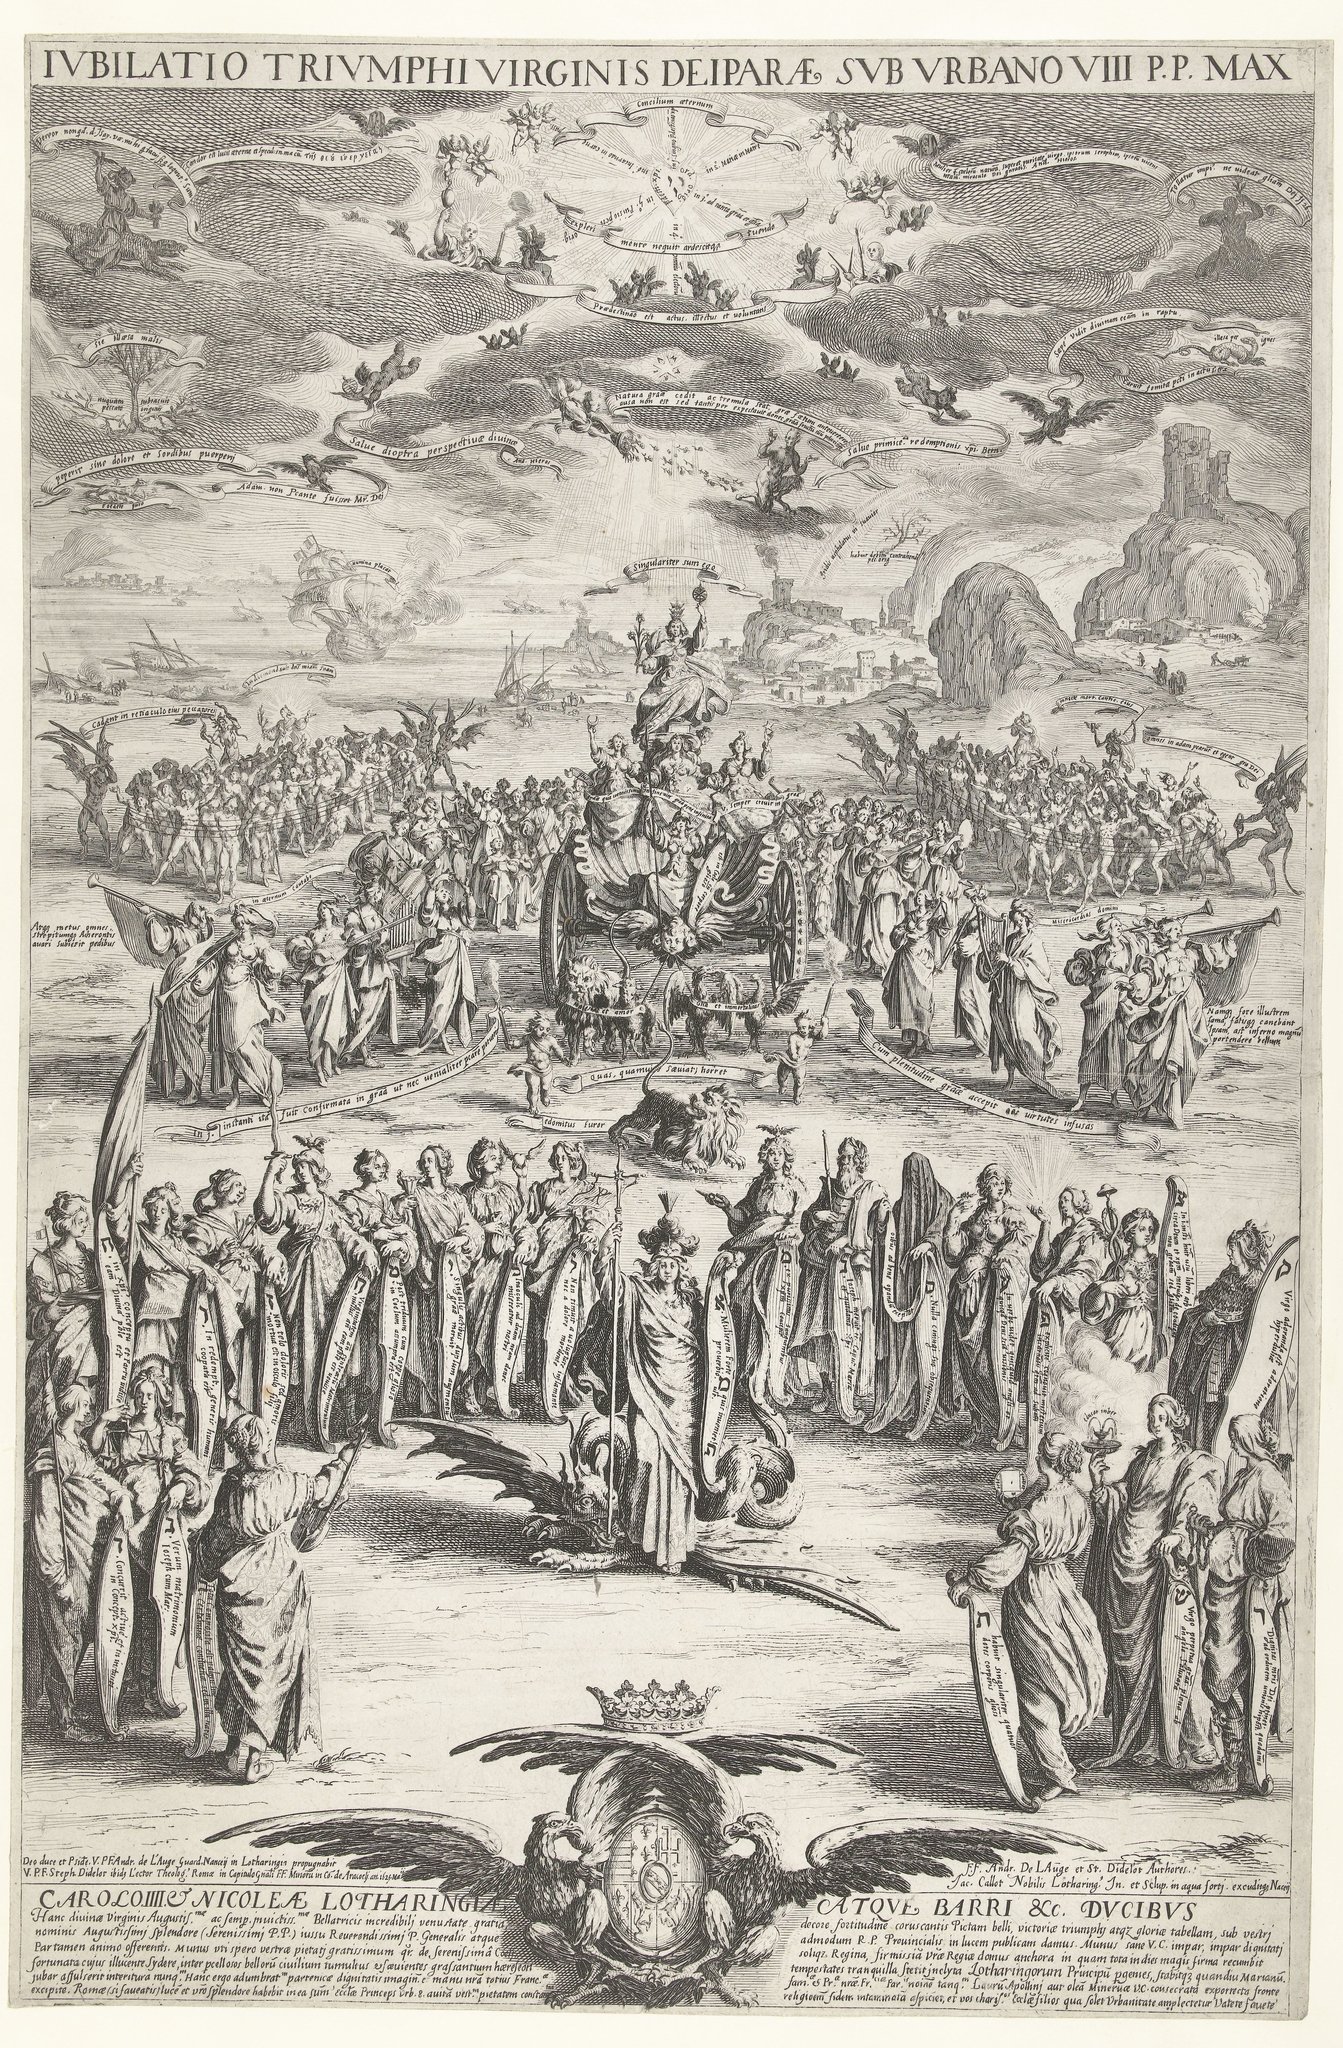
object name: promotieprent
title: La petite thèse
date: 1625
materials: paper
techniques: etching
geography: nancy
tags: paris, nicola (hertogin van lotharingen), karel iv hertog van lotharingen, musician, predatory birds: eagle, large group of musicians, orchestra, chariot, triumphal car, triumph of mary, on triumphal chariot, dragon, symbols of mary, coast, armorial bearing, heraldry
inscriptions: collector's mark: Lugt 240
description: Op de voorgrond allegorische figuren in een kring om een dame die een draak vertrapt. Daarachter Maria op een triomfwagen getrokken door een leeuw, een lam, een adelaar en een feniks. Om haar heen een menigte vrouwelijke muzikanten. Links en rechts achter deze musici groepen verdoemden die door duivels gevangen gehouden worden. Op de achtergrond een rotsachtig kustlandschap. Aan de hemel engeltjes en diverse symbolen. Her en der bij de figuren banderollen en schilden met Latijnse teksten. Boven de voorstelling een opschrift in het Latijn. Onder de voorstelling het wapenschild van de hertogen van Lotharingen en een onderschrift in het Latijn. Prent verschenen ter gelegenheid van de promotie van de Franciscaner monniken André de l'Auge (Ange?) en Etienne Didelot in mei 1625.